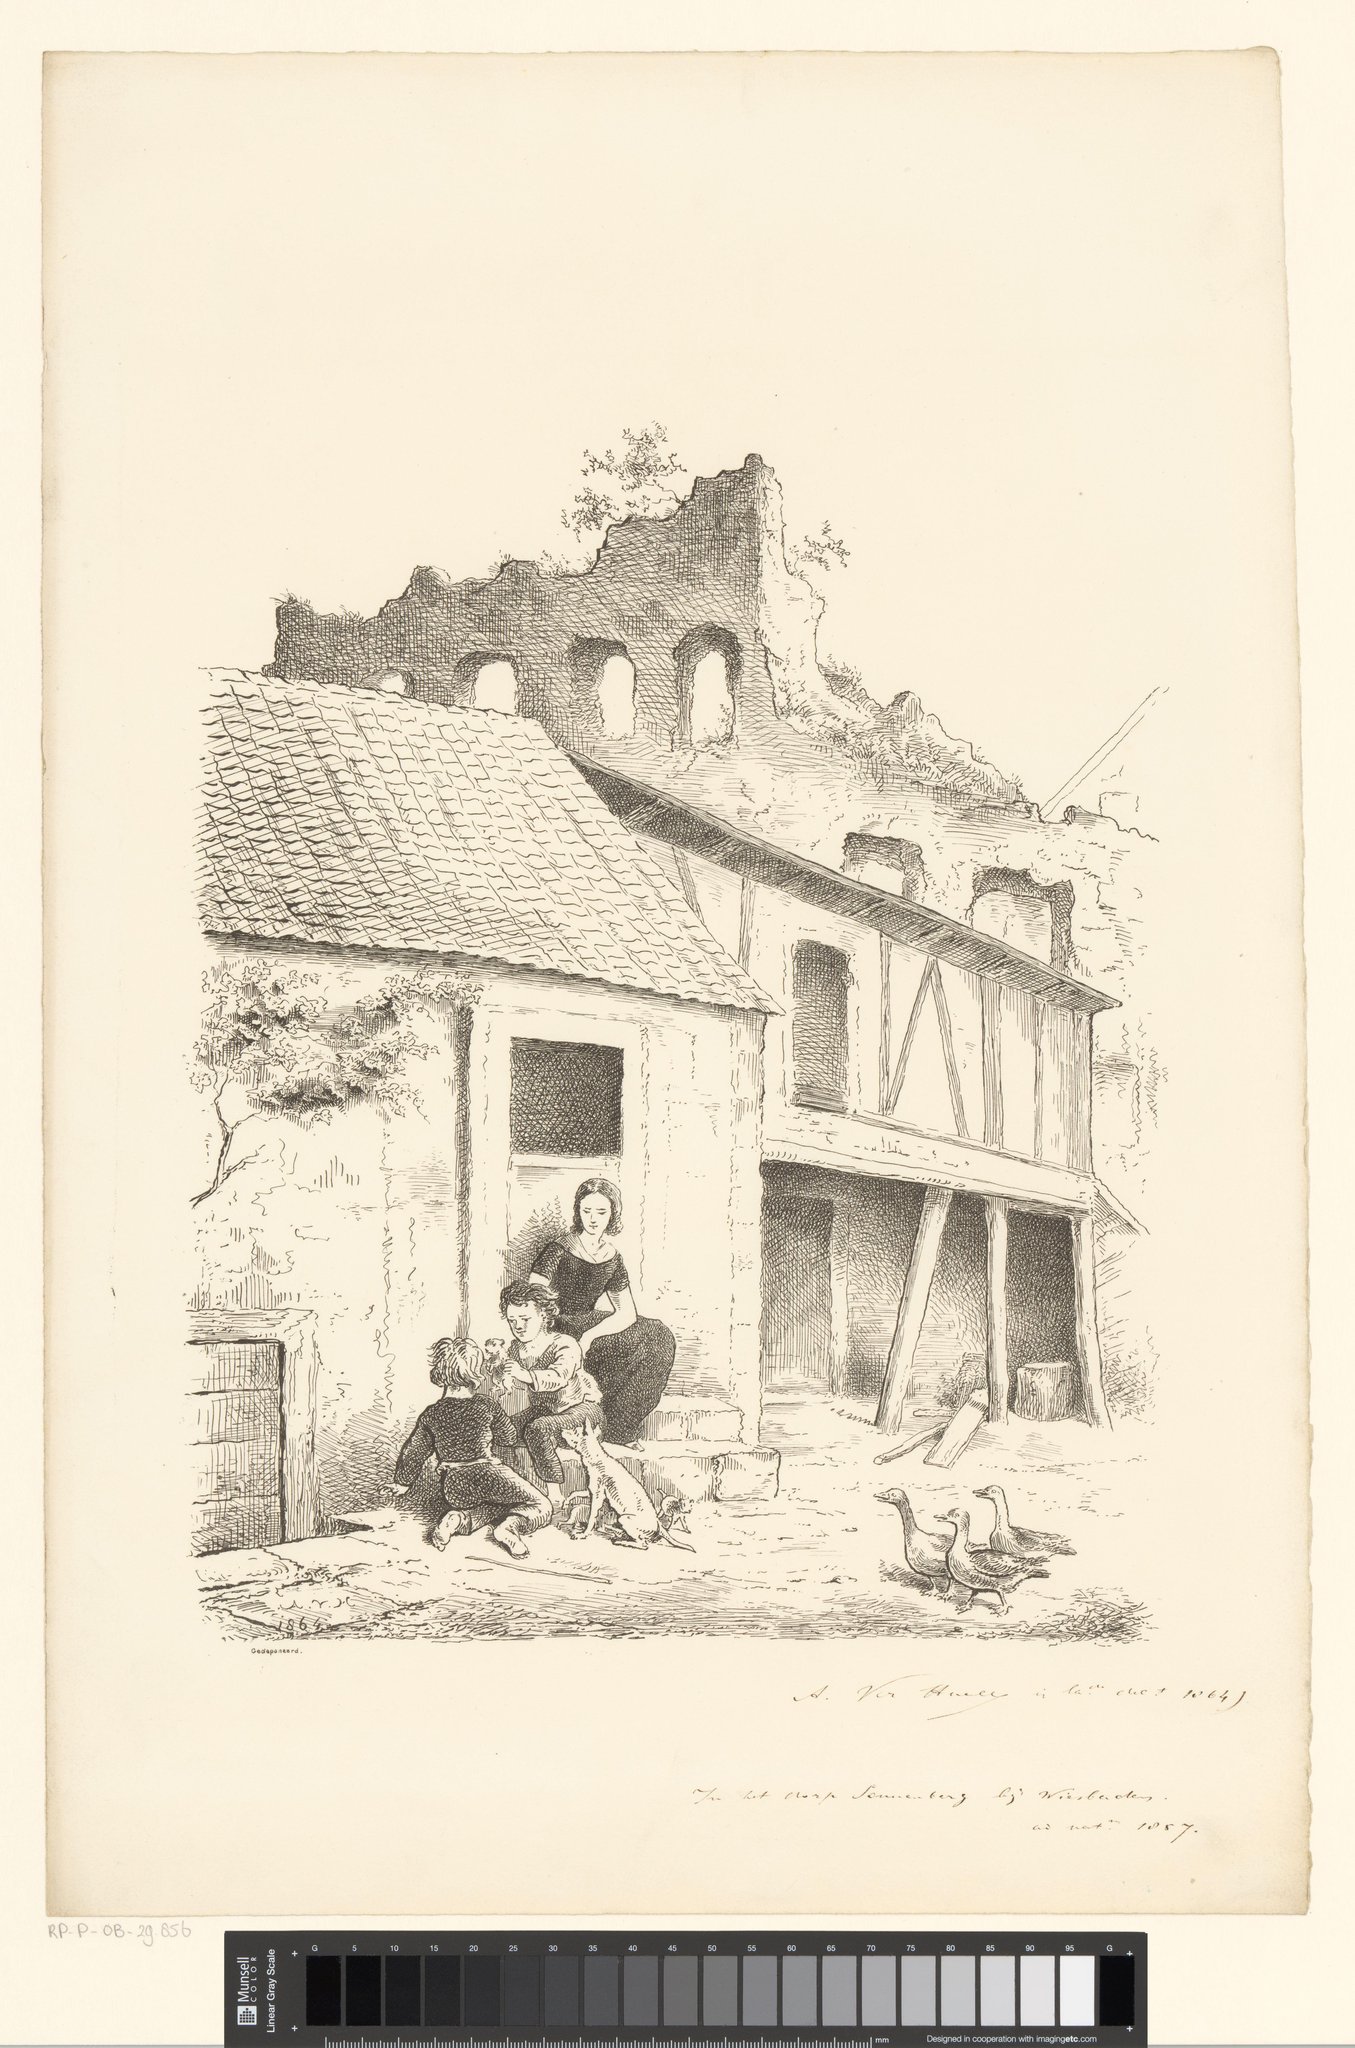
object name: print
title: Uit het verleden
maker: alexander ver huell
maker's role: draughtsman, print maker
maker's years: 1822-1897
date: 1864-1866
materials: paper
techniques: lithograph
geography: arnhem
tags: mother and child(ren), woman and child(ren) (family group), dog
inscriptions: : ‘Gedeponeerd.’, collector's mark: Lugt 2228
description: Een vrouw zit met haar twee kinderen op de stoep voor haar huis in het dorp Sonnenberg bij Wiesbaden. De kinderen spelen met de puppy's van de hond die naast hen zit. In de achtergrond een ruïne.